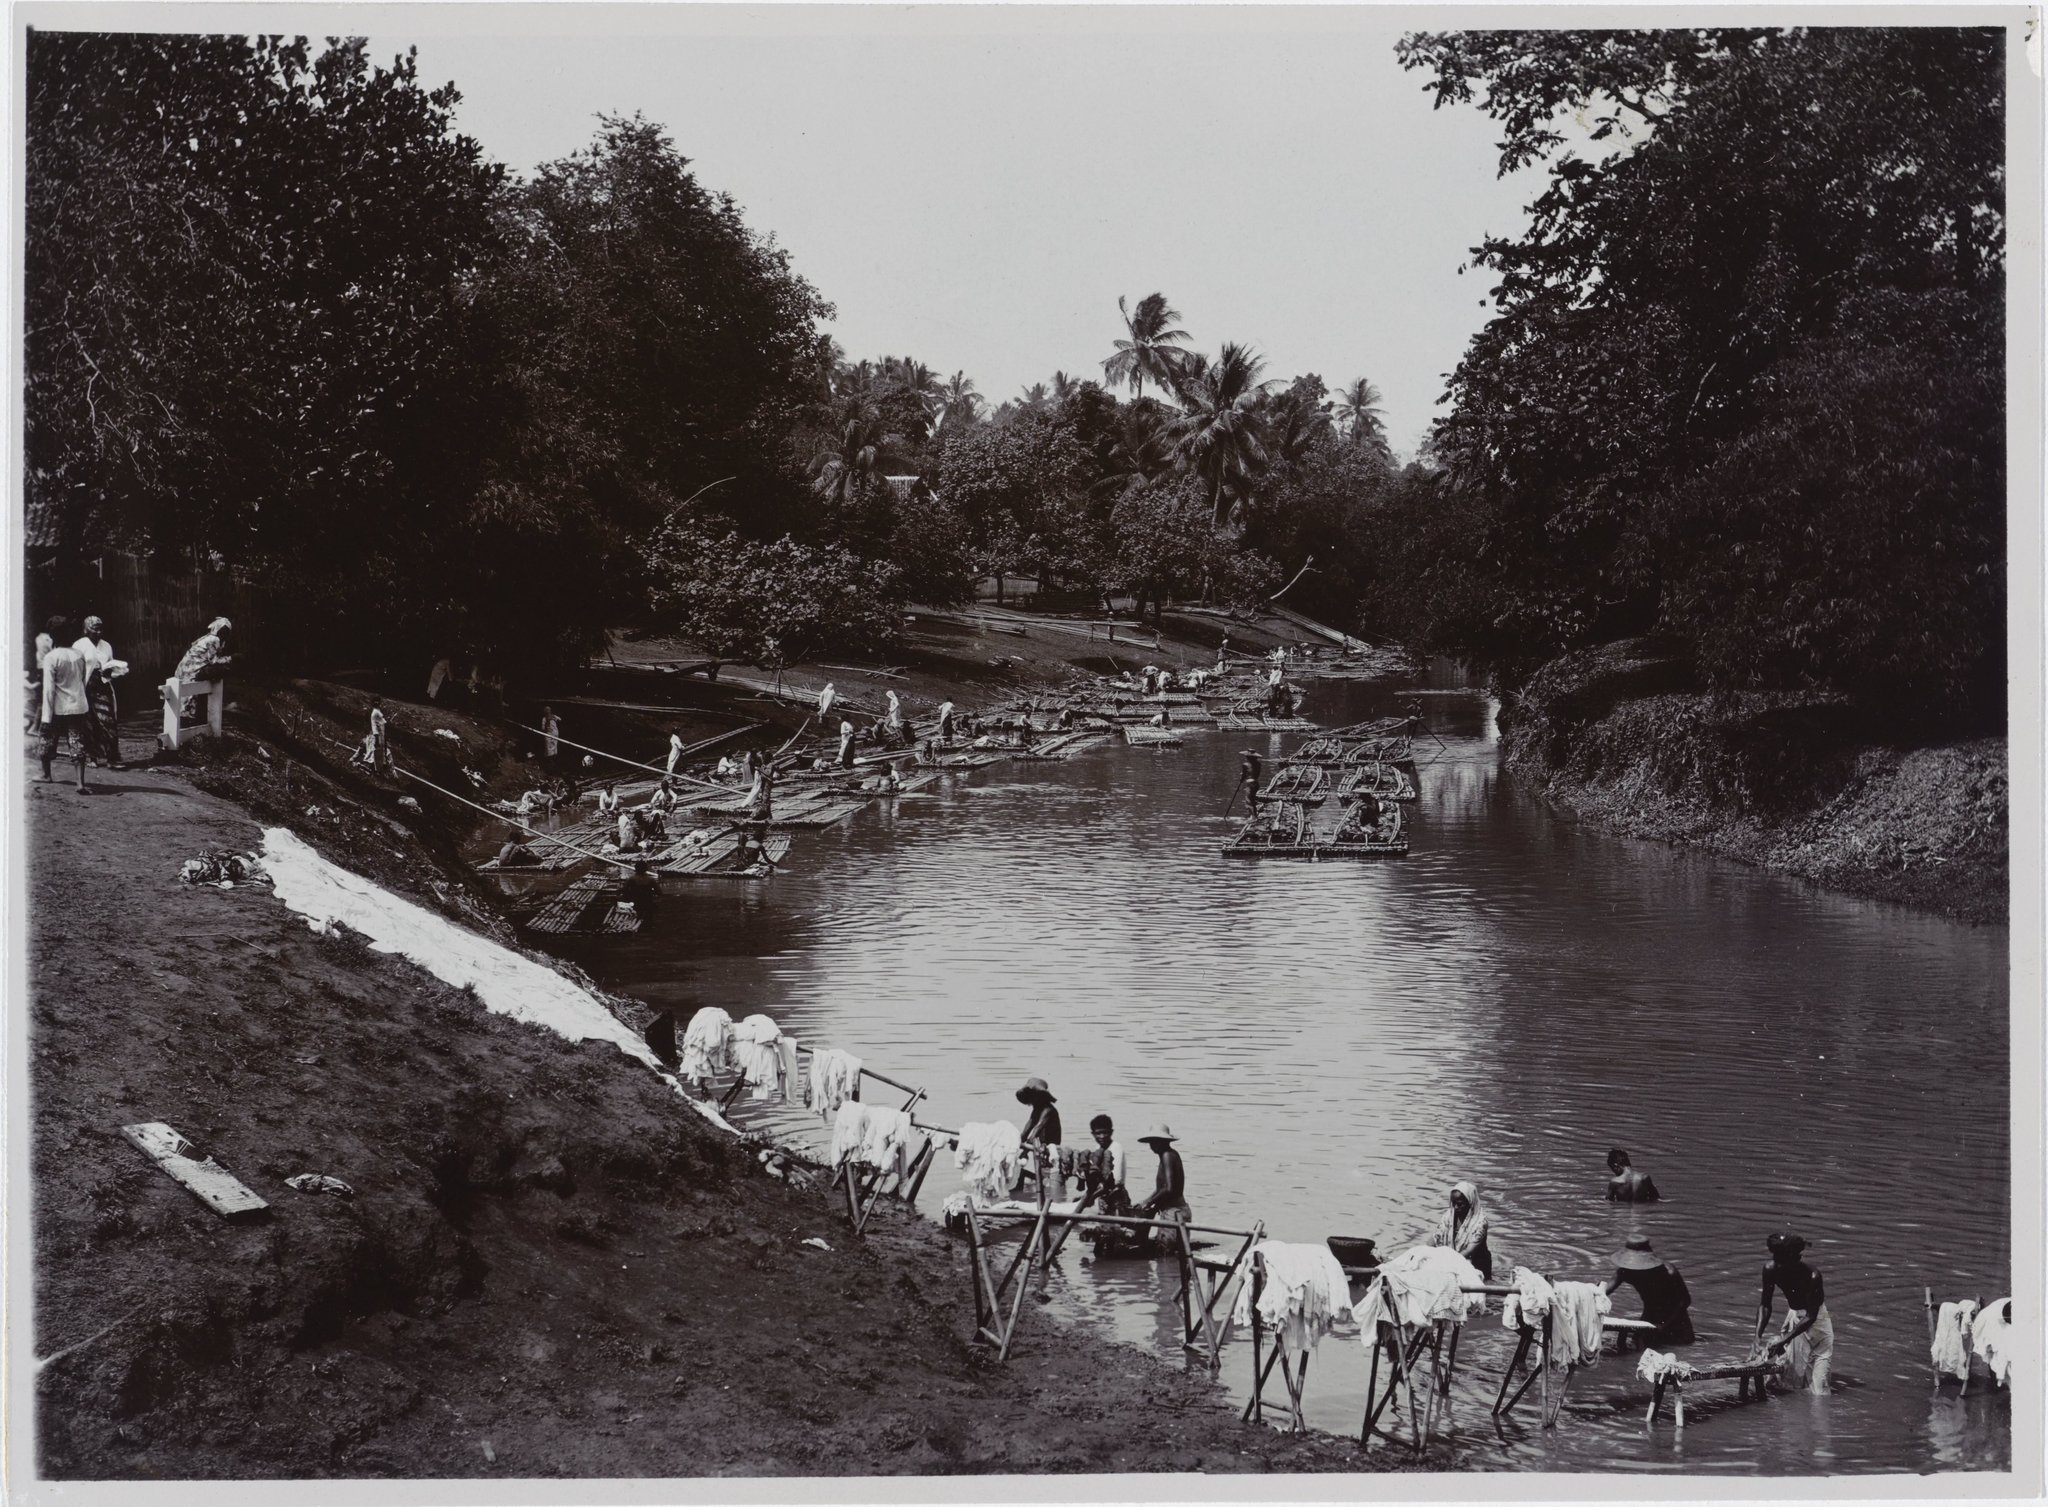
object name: photograph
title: Activiteit op een rivier in Indonesië met vlotten en wassende mensen.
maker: johanna hermina marmelstein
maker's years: 1897-1990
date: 1900-1915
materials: paper, photographic support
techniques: albumen print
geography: jakarta